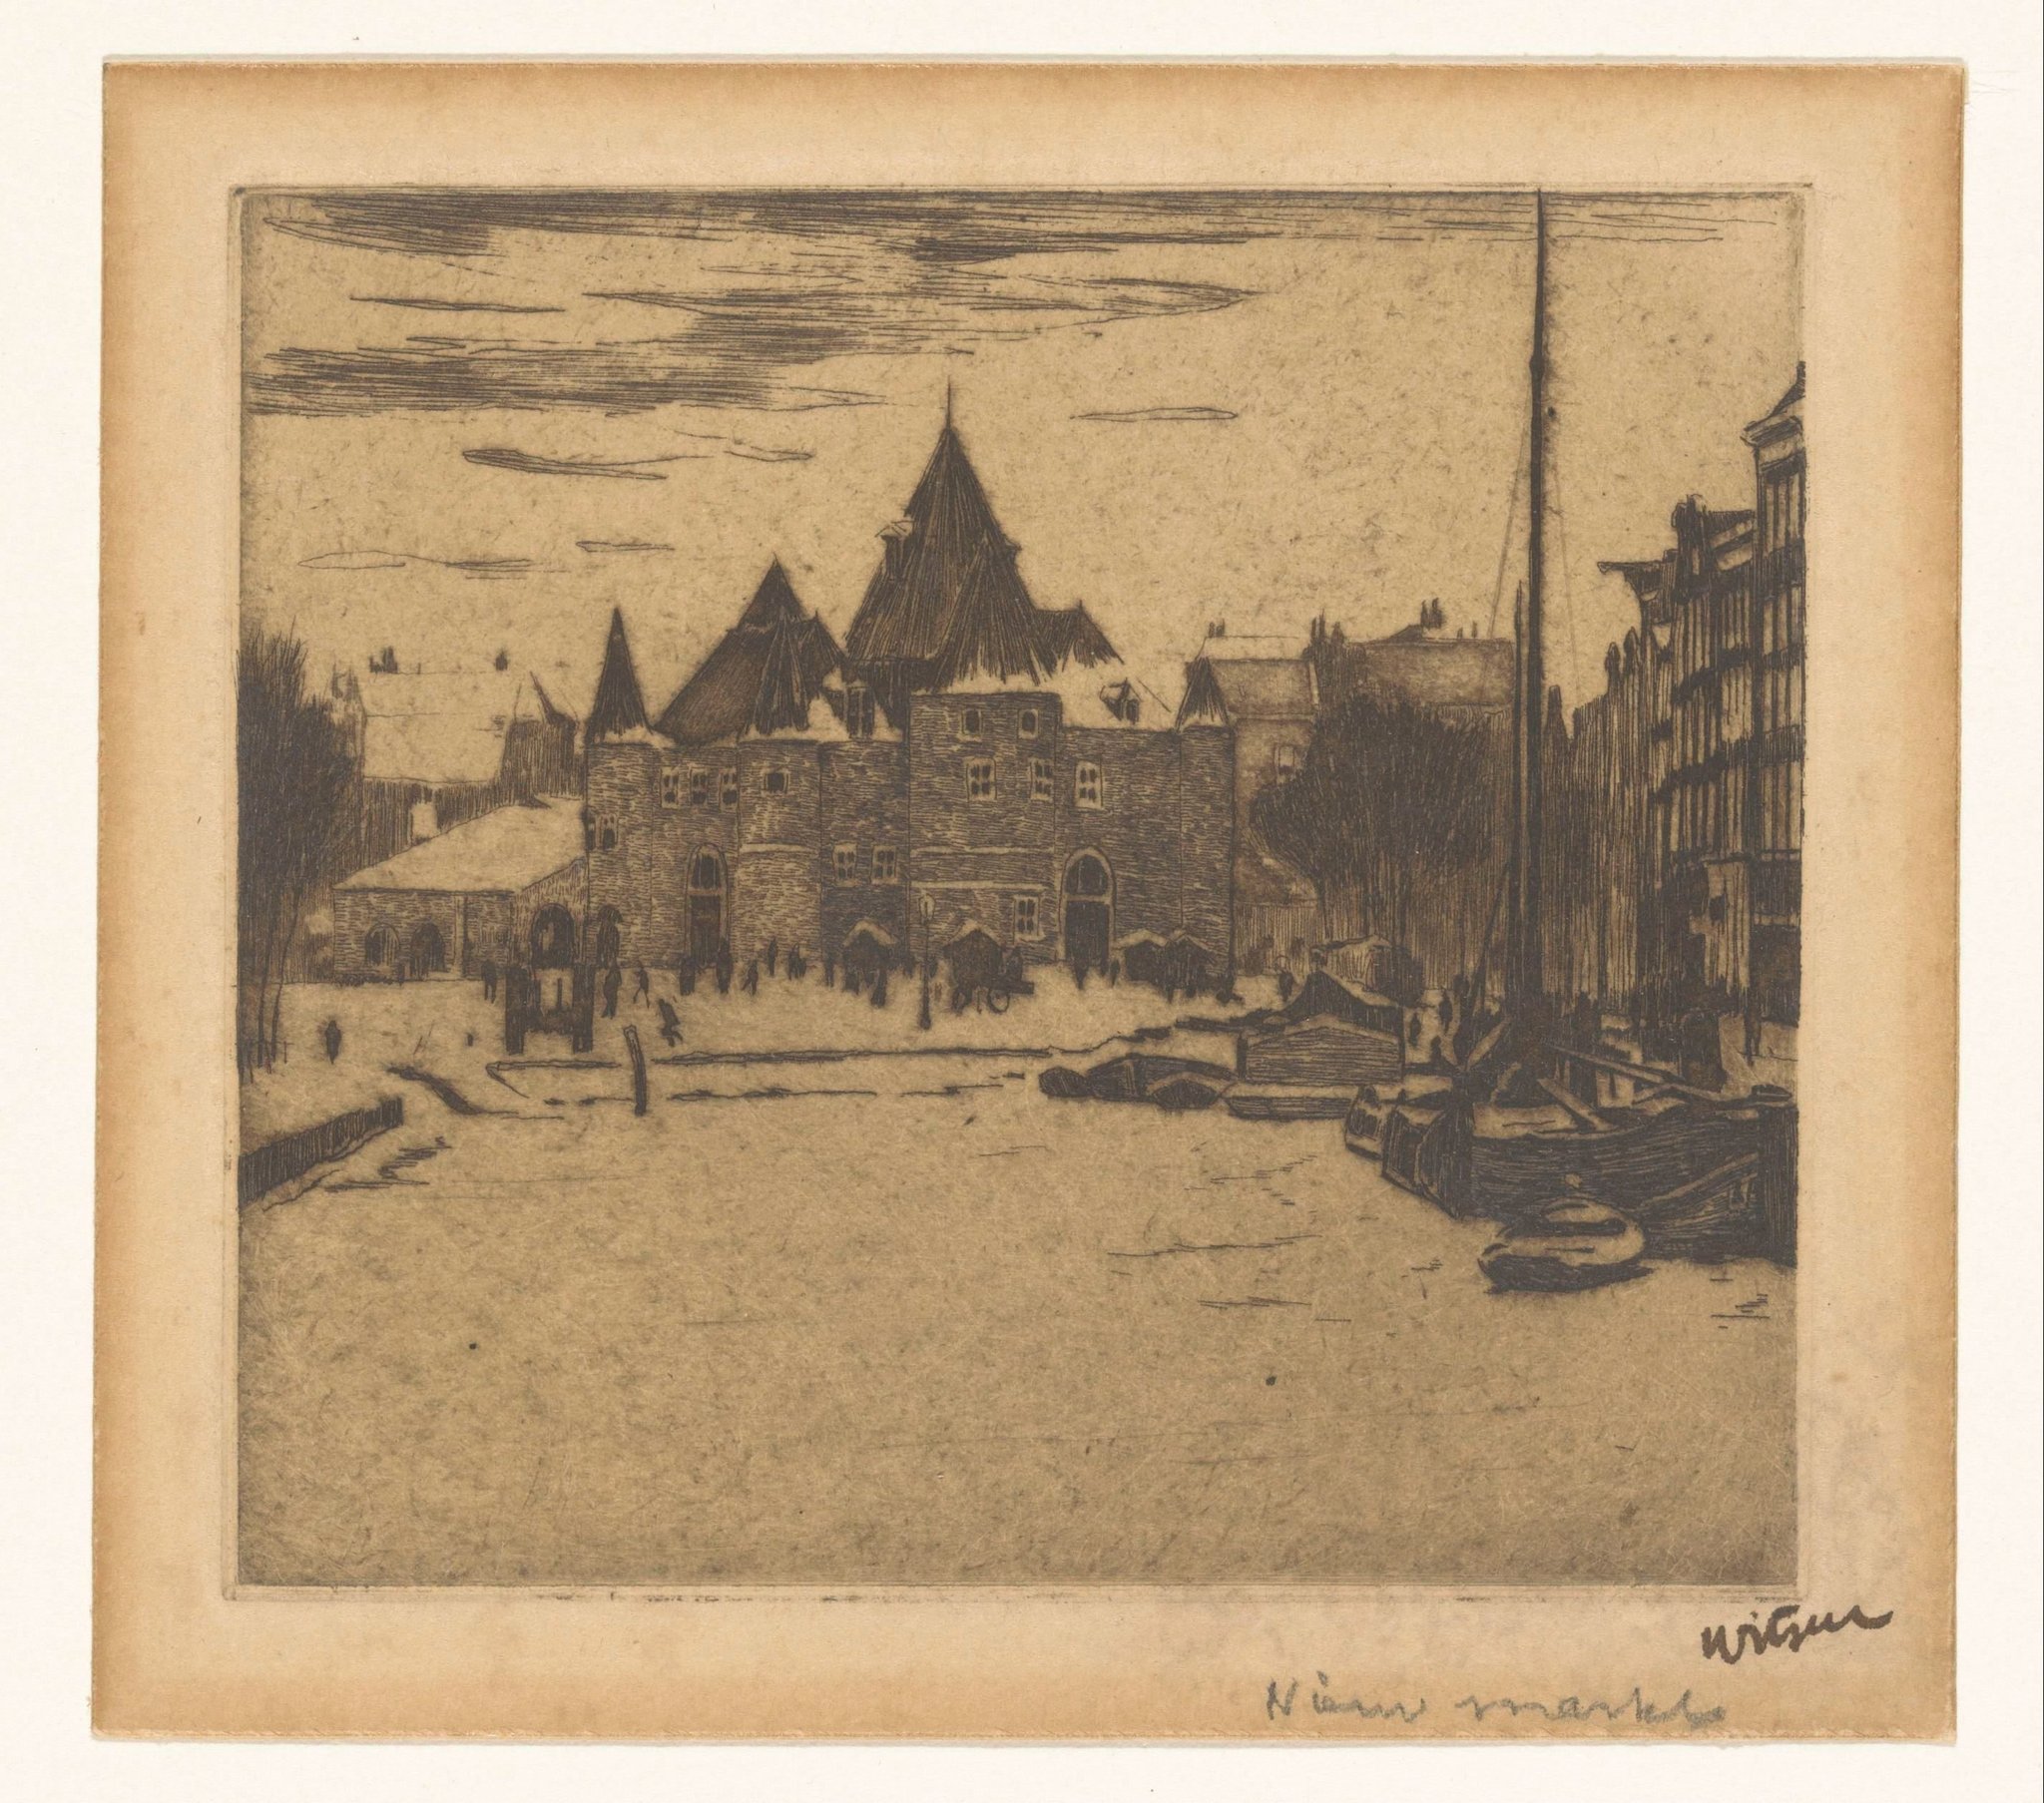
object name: print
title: Nieuwmarkt in Amsterdam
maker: willem witsen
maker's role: draughtsman, painter, print maker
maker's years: 1860-1923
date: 1897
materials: paper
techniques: etching, intaglio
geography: amsterdam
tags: urban housing, city-view, and landscape with man-made constructions, city dwellers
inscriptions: signature: ‘Witsen’, inscription: ‘Nieuw markt’